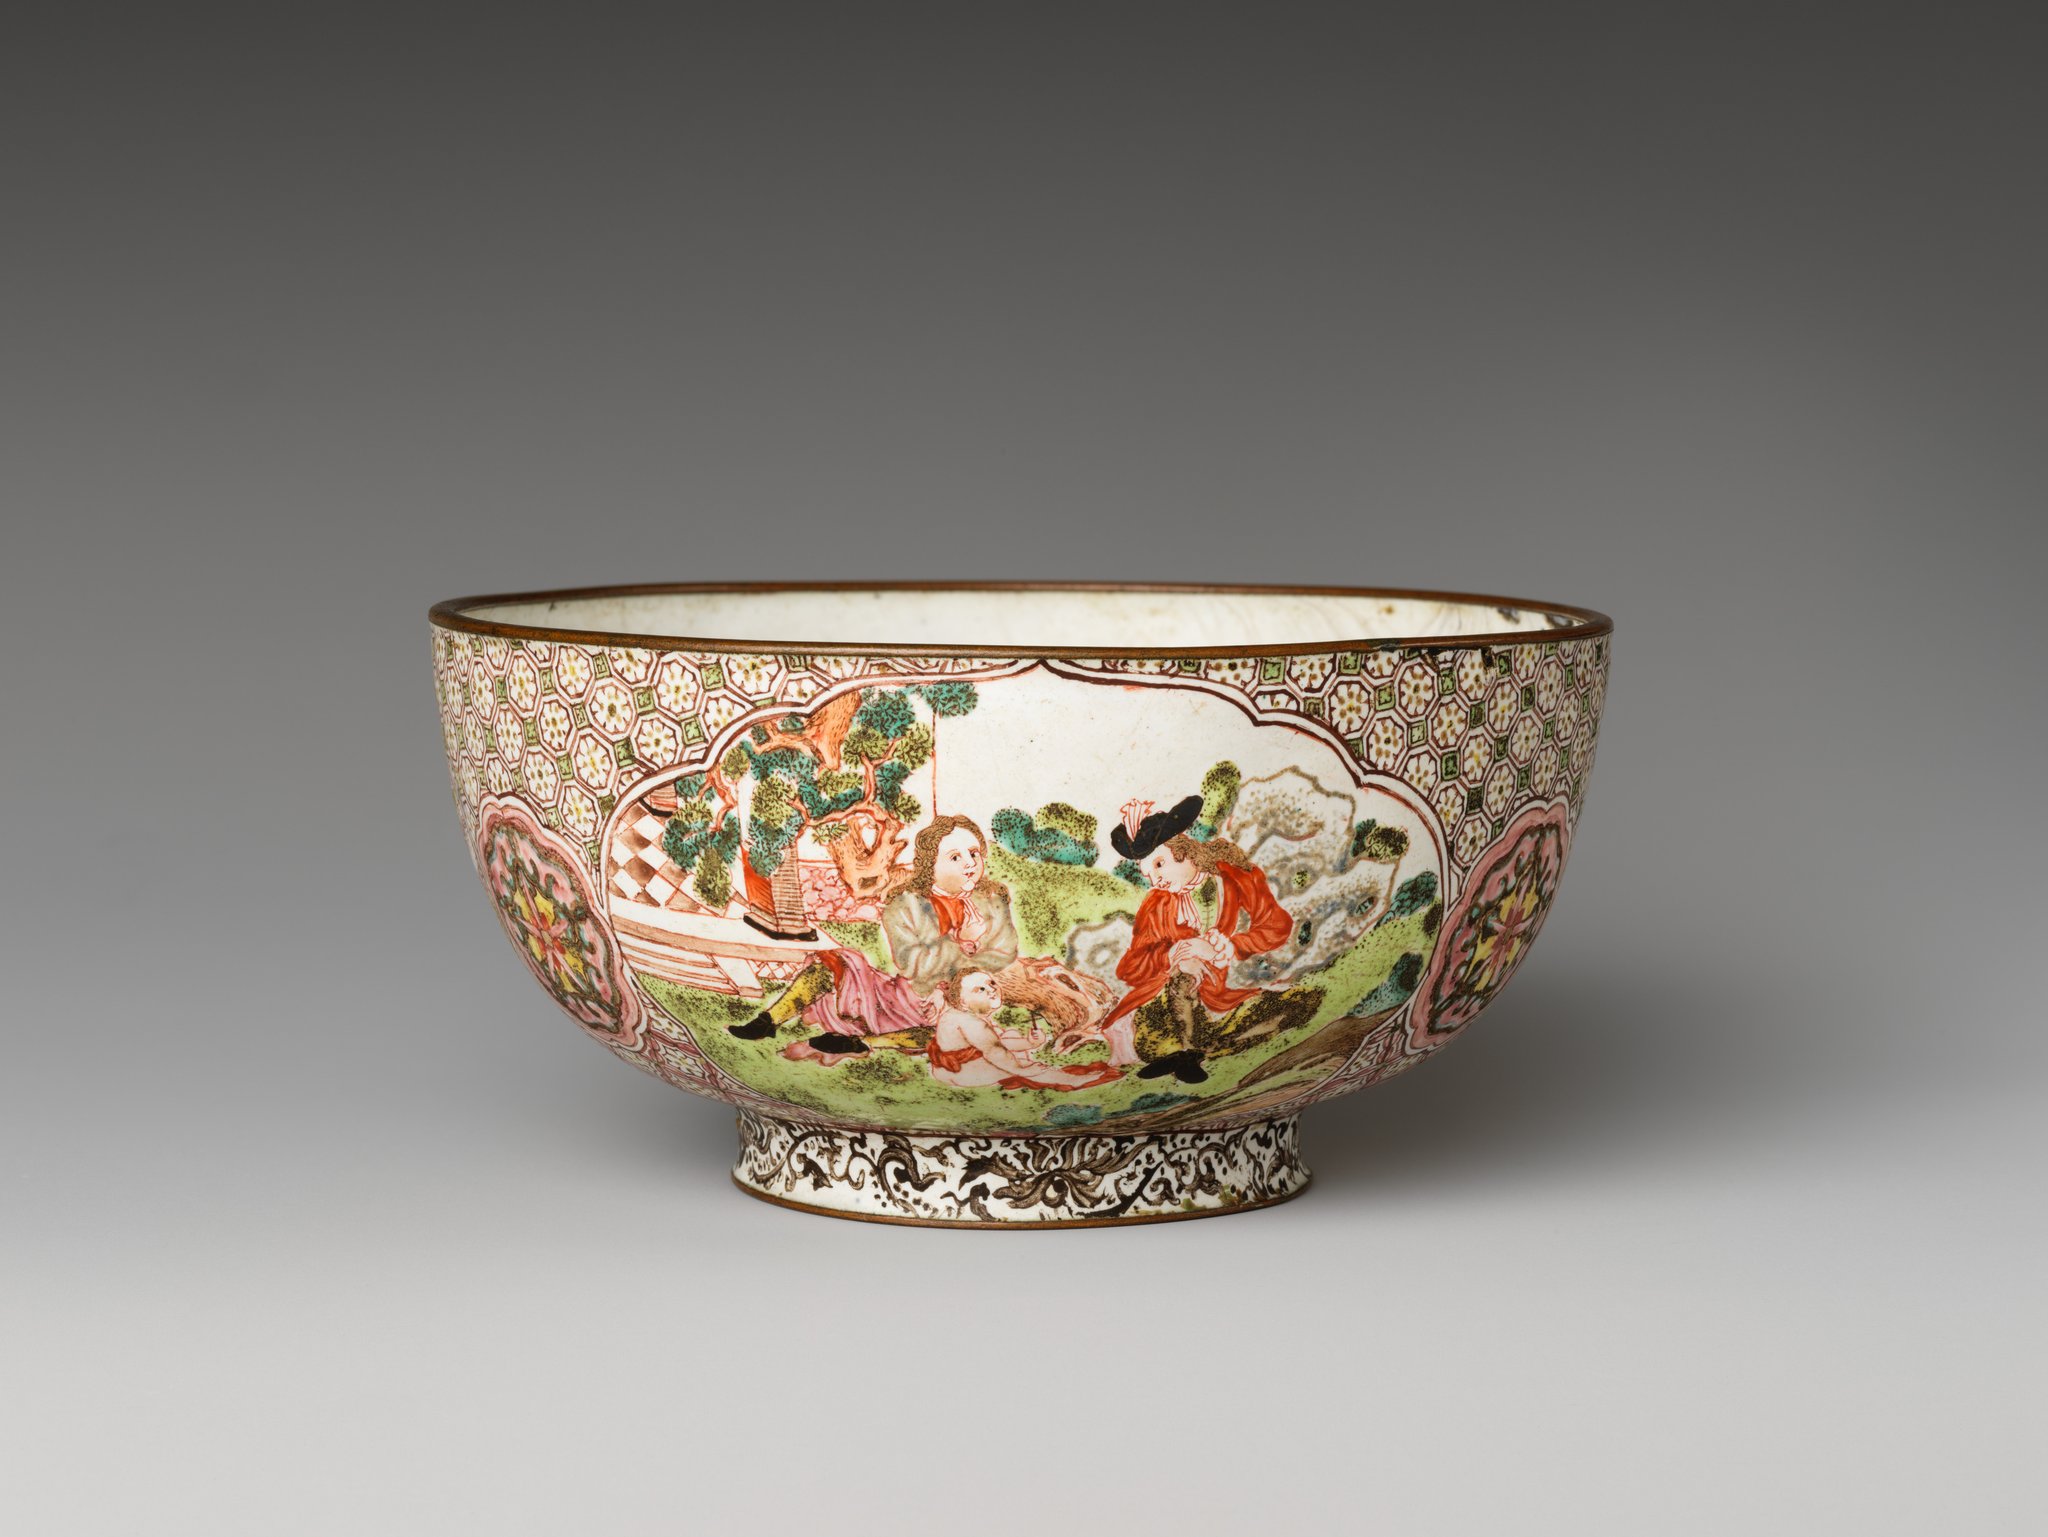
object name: bowl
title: Bowl (one of a pair)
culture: chinese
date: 1736-1795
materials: enamel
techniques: painting